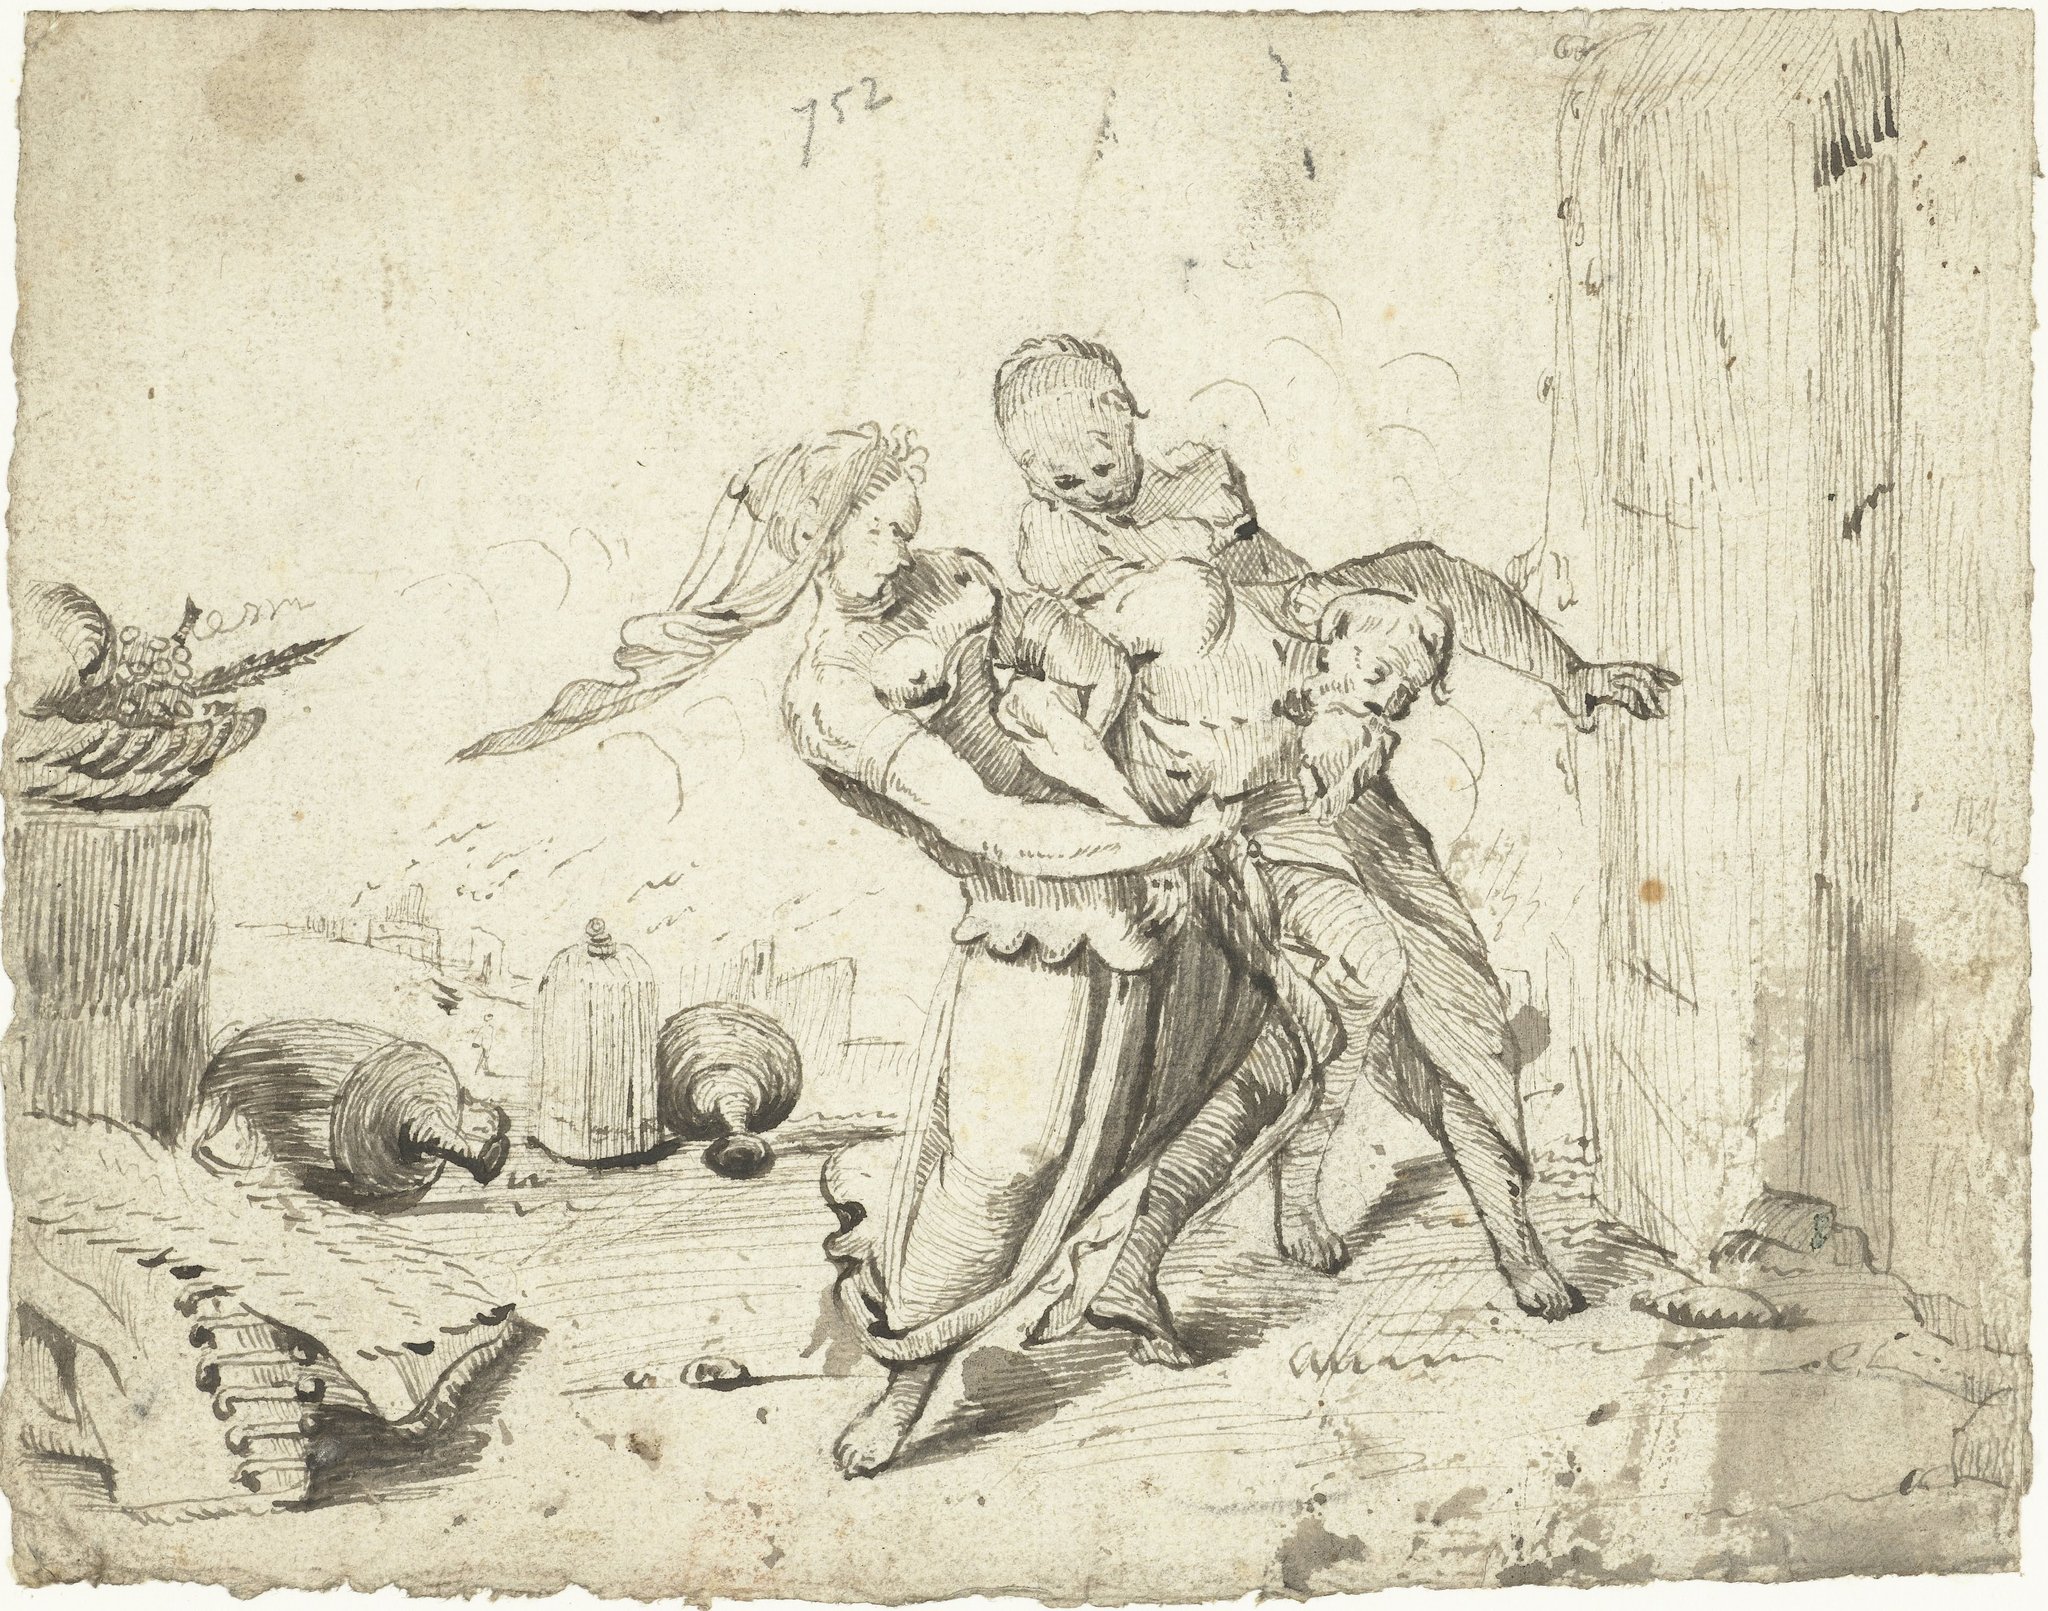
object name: drawing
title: Lot en zijn dochters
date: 1622-1640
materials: chalk, ink, paper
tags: lot and his daughters (genesis 19:30-38)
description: Kopie van Gerard ter Borch naar tekening GSr 86, als voorbereiding van ets GSr 1 [Etchings], of kopie naar deze ets door één van zijn zonen.